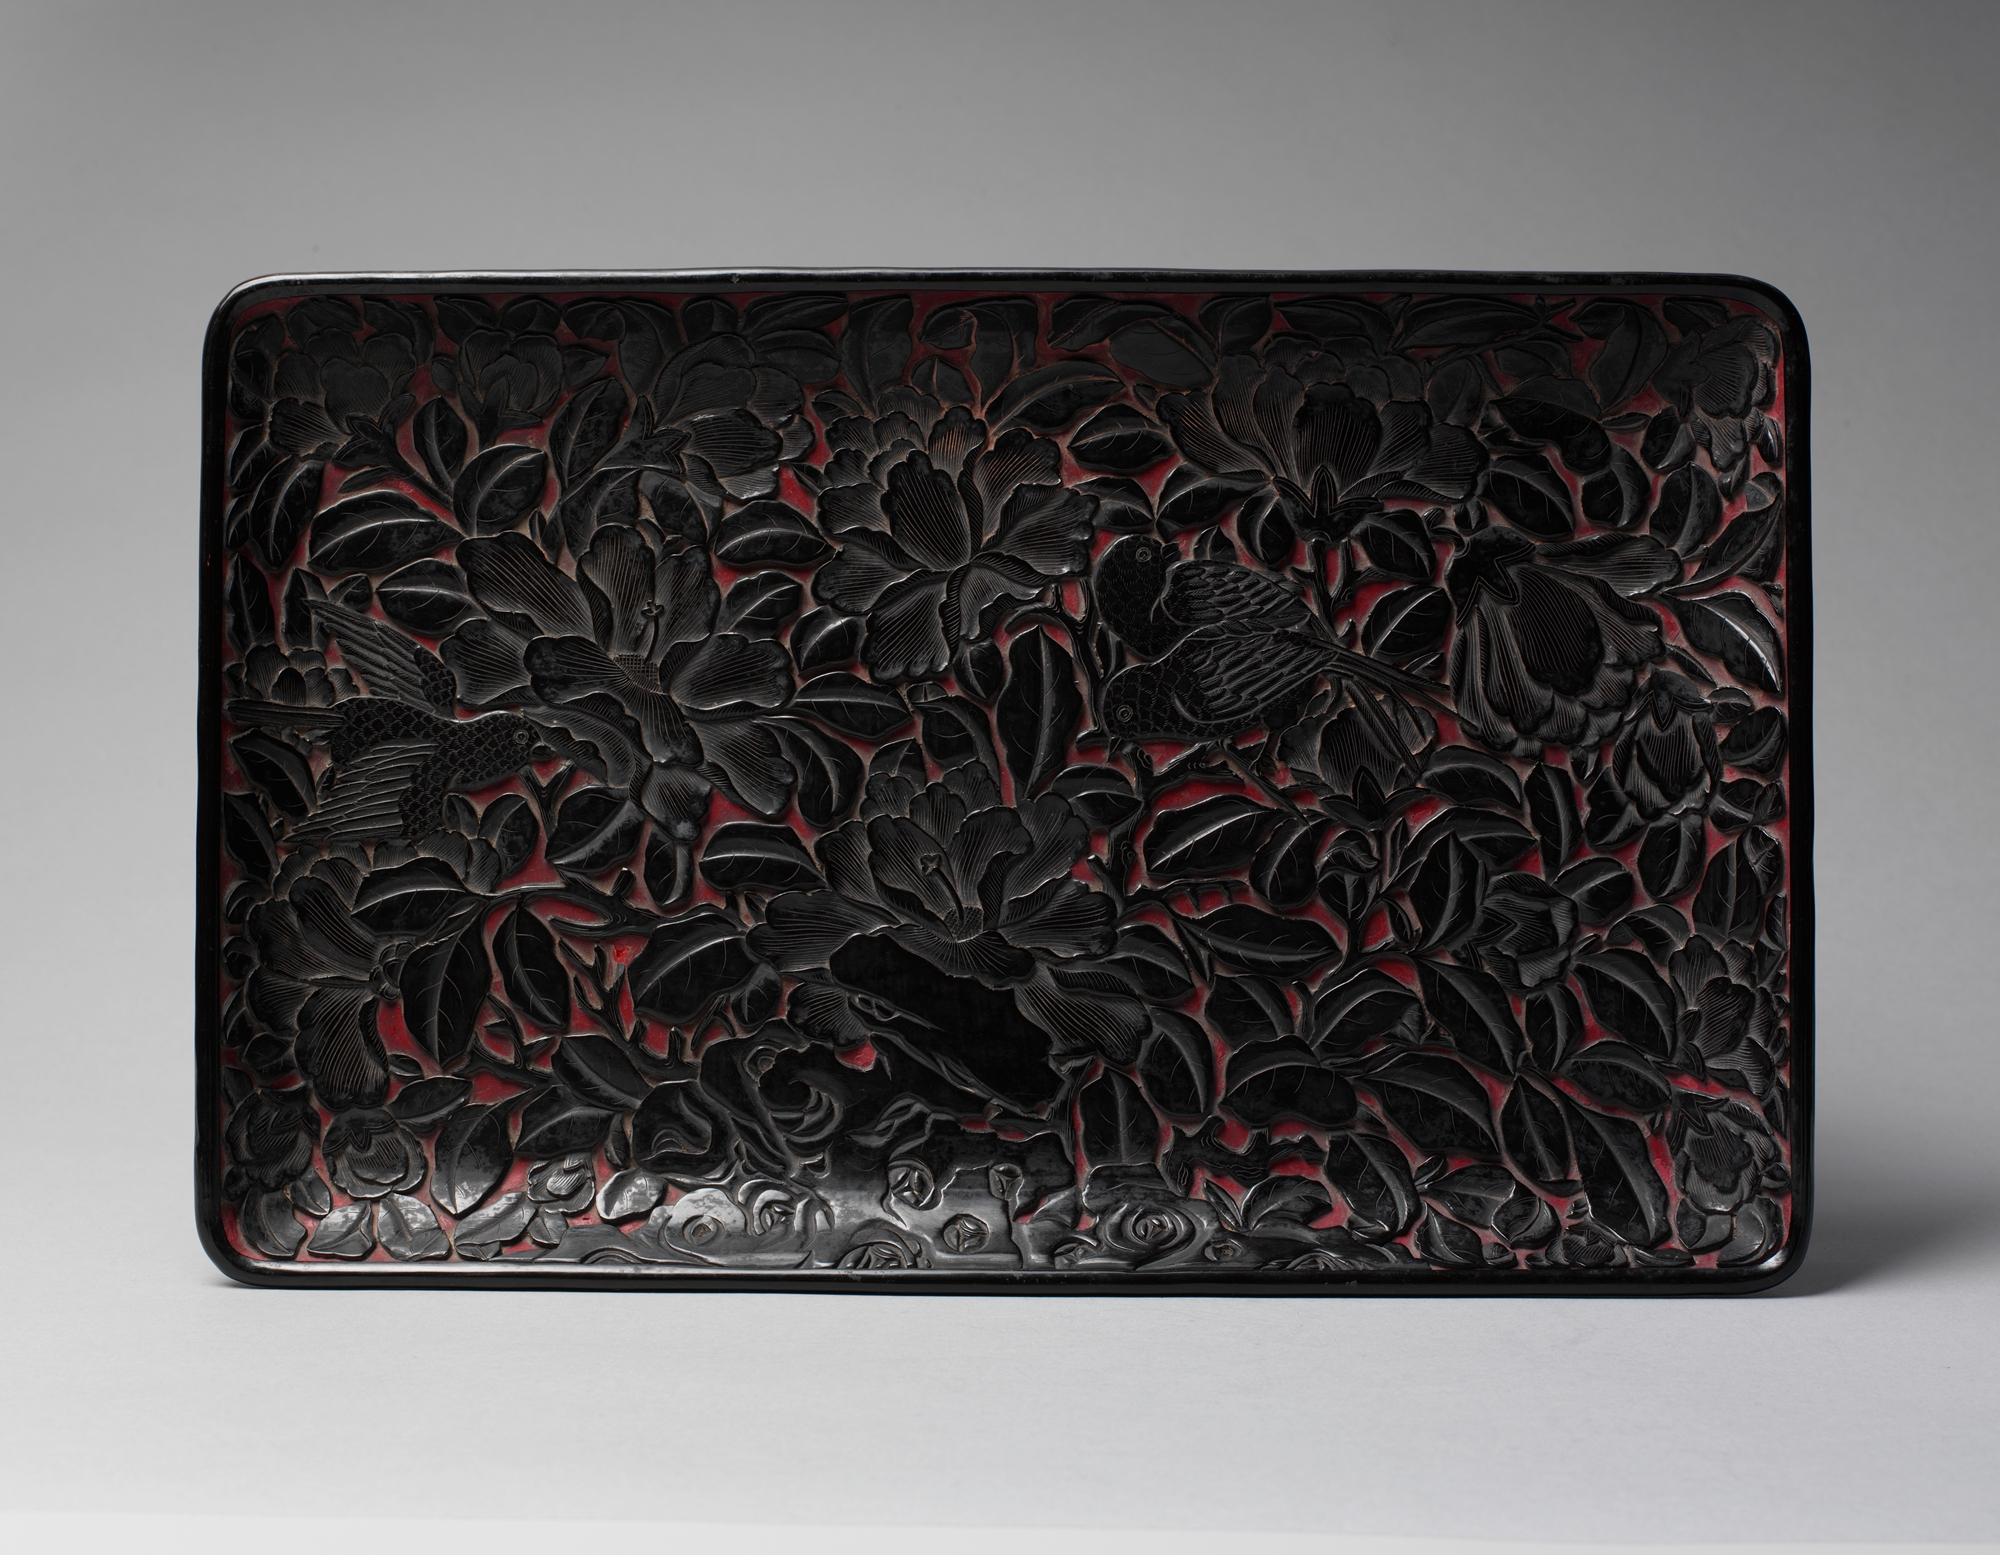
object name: tray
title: Rectangular tray with peonies and birds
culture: chinese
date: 1501-1600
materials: lacquer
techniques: carving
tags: birds,peonies